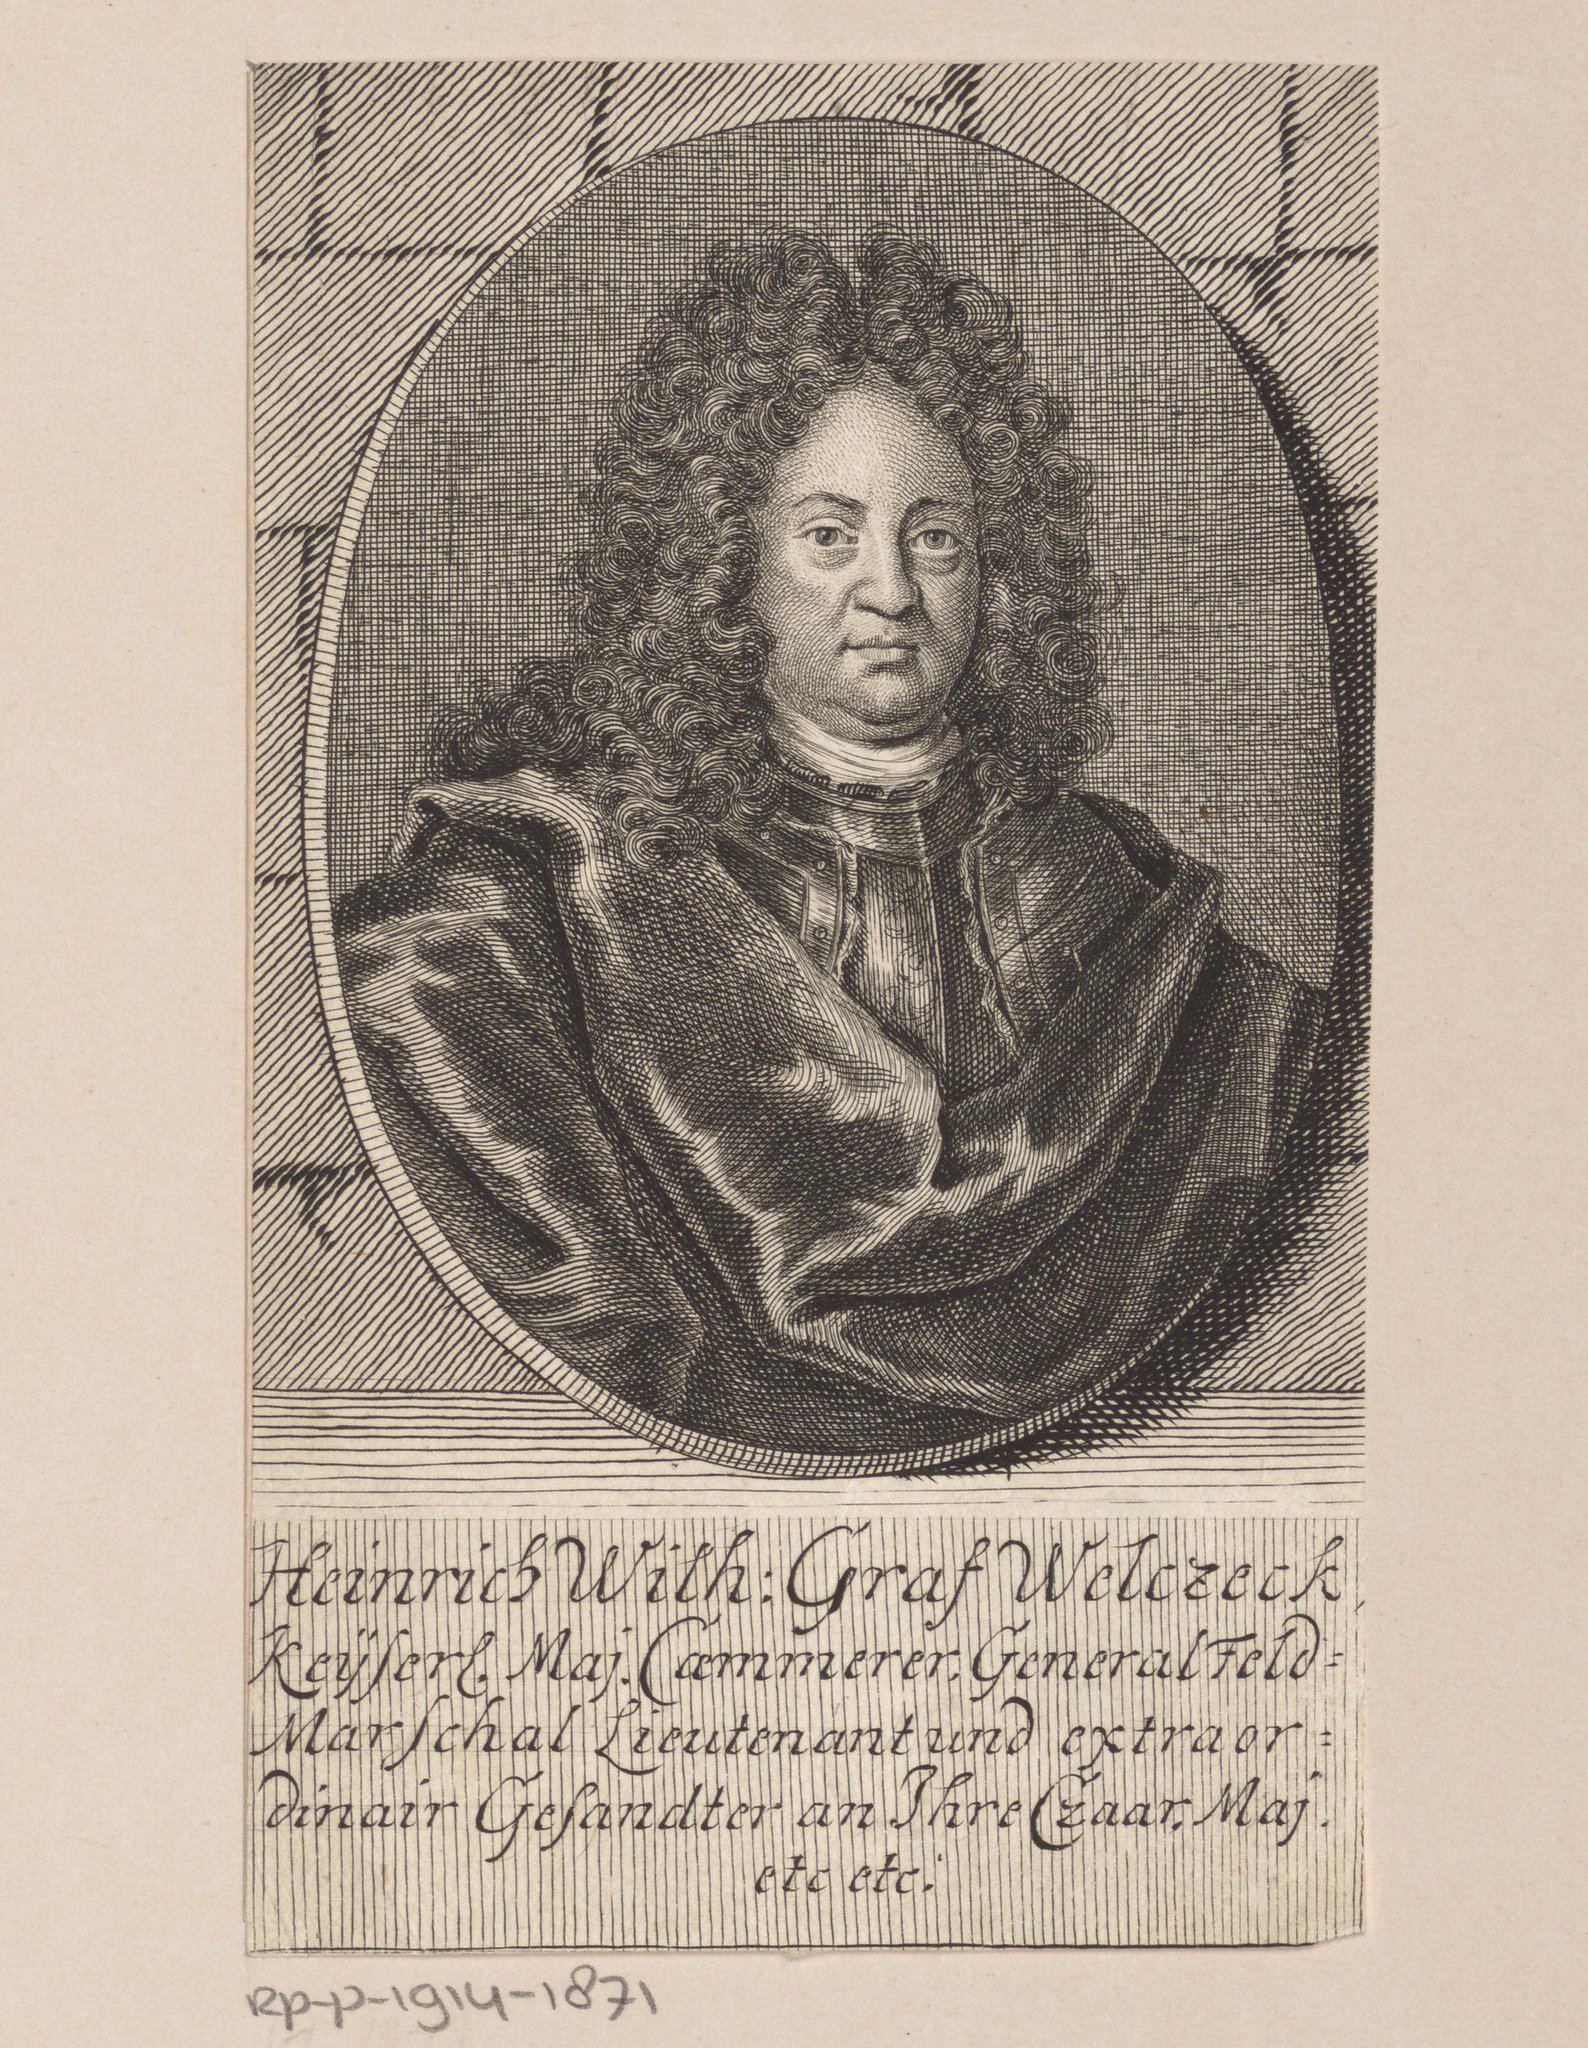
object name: print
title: Heinrich Wilh Graf Welczeck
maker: martin bernigeroth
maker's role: print maker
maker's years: 1670-1733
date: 1710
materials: paper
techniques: engraving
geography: leipzig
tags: historical persons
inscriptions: collector's mark: Lugt 2228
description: Prent waarschijnlijk uit: Die Europäische Fama, nr. 106, 1710.